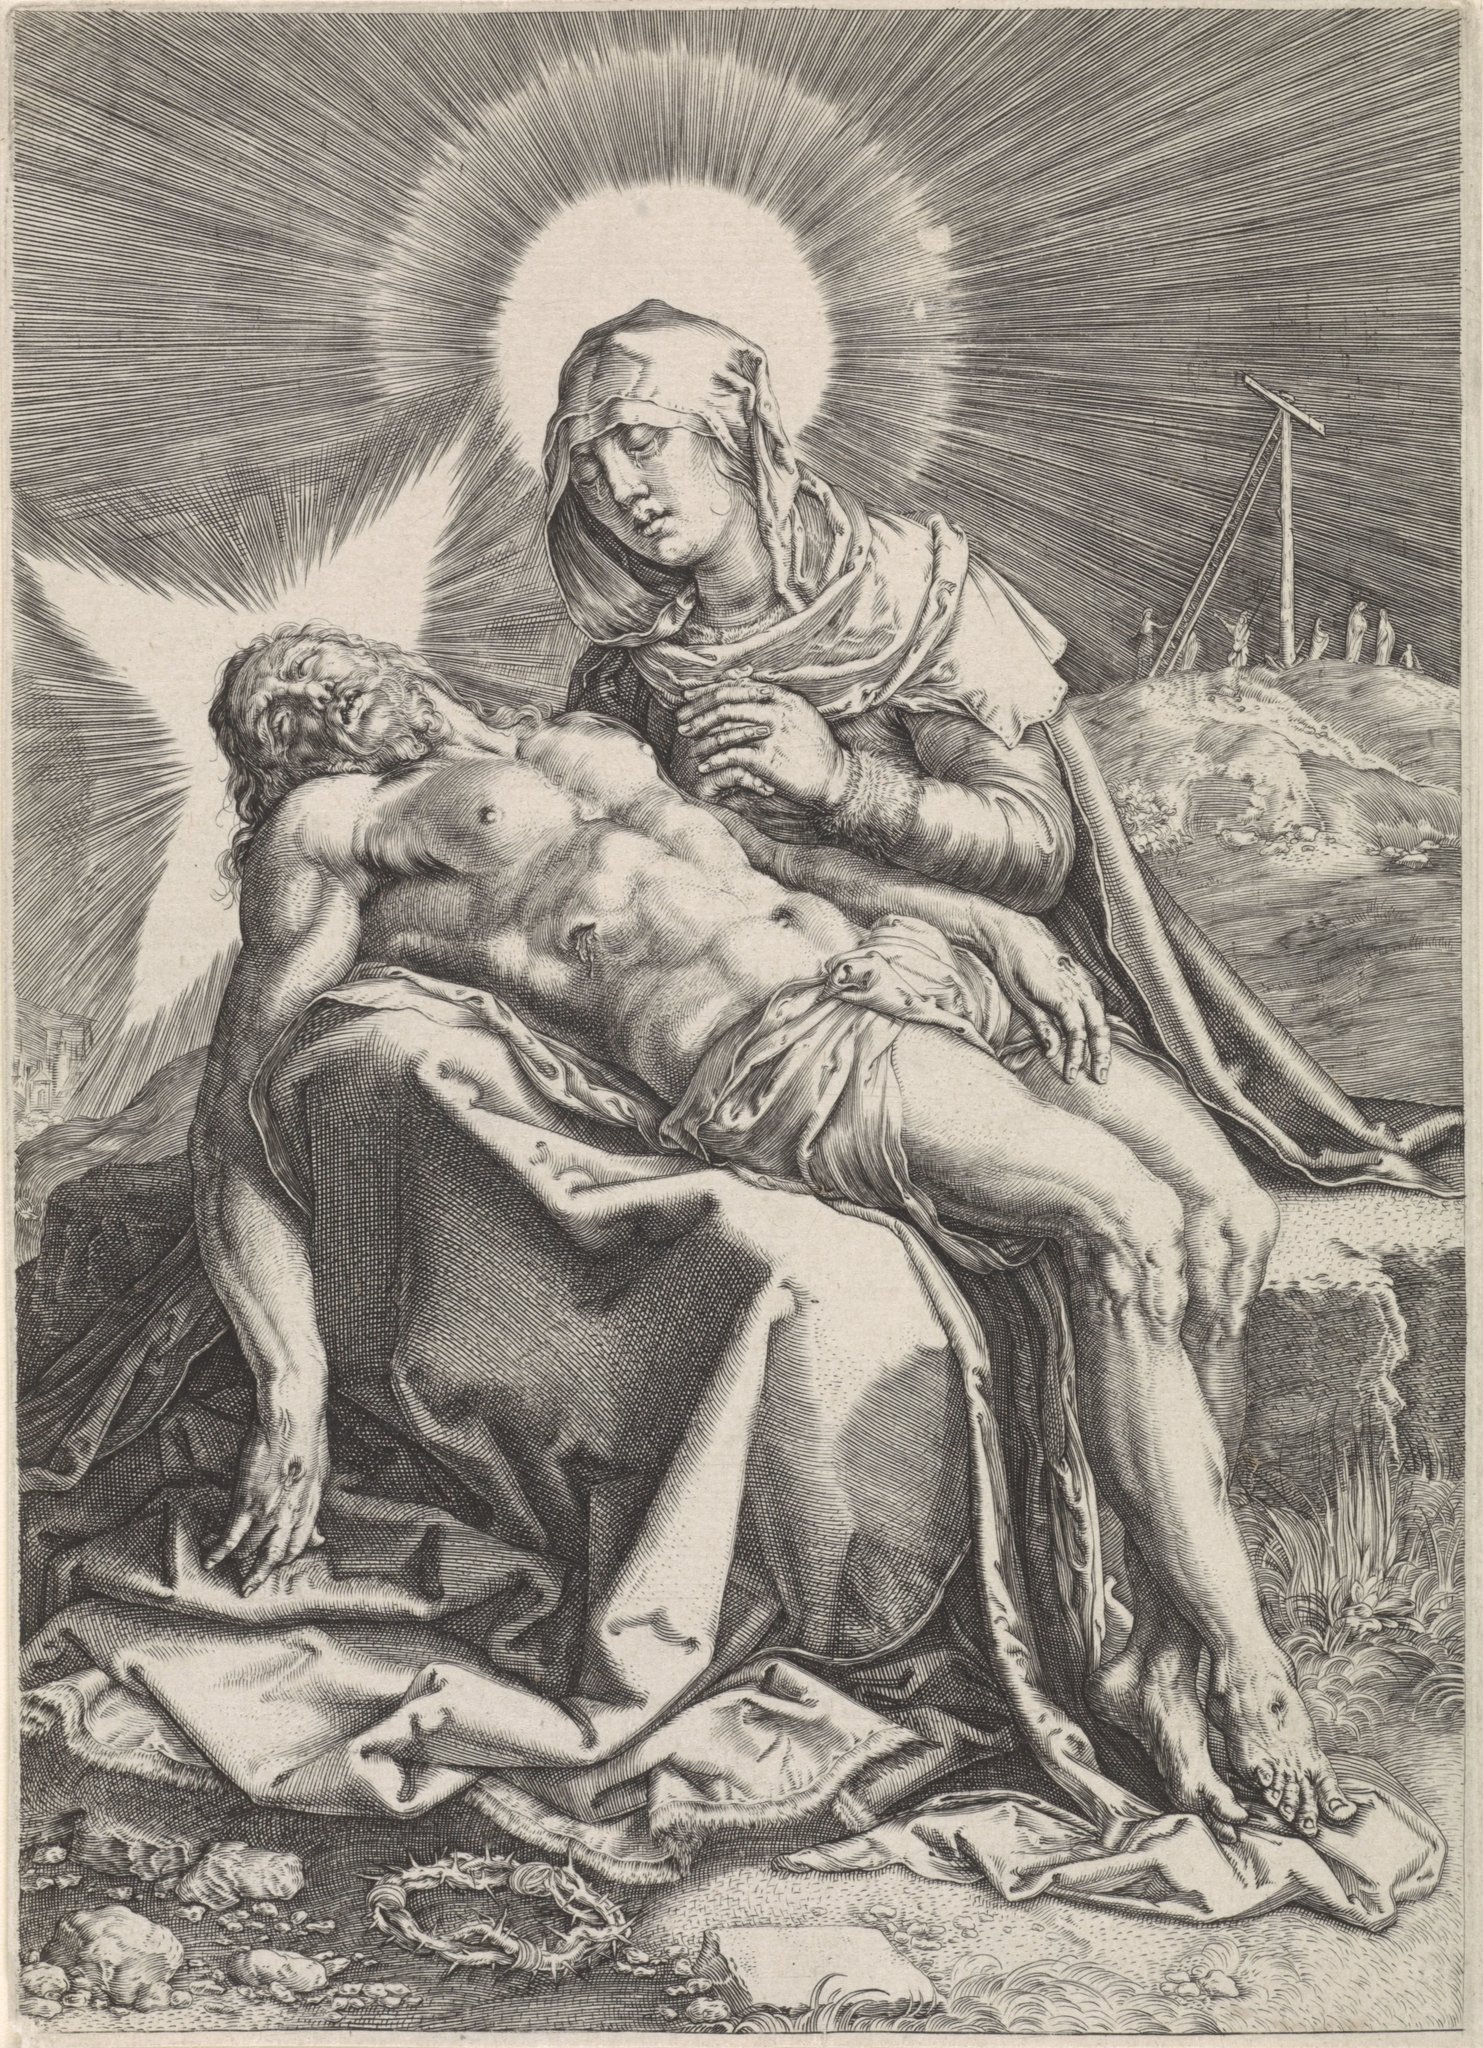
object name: print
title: Piëta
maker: Anonymous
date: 1596-1667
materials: paper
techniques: engraving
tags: 'pietà ', 'vesperbild', 'marienklage' (no others present): christ, either with or without crown of thorns, mourned by mary, the dead christ in mary's lap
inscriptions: collector's mark: Lugt 240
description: Maria met de gestorven Christus in de armen, hem bewenend, zittend op een steen.